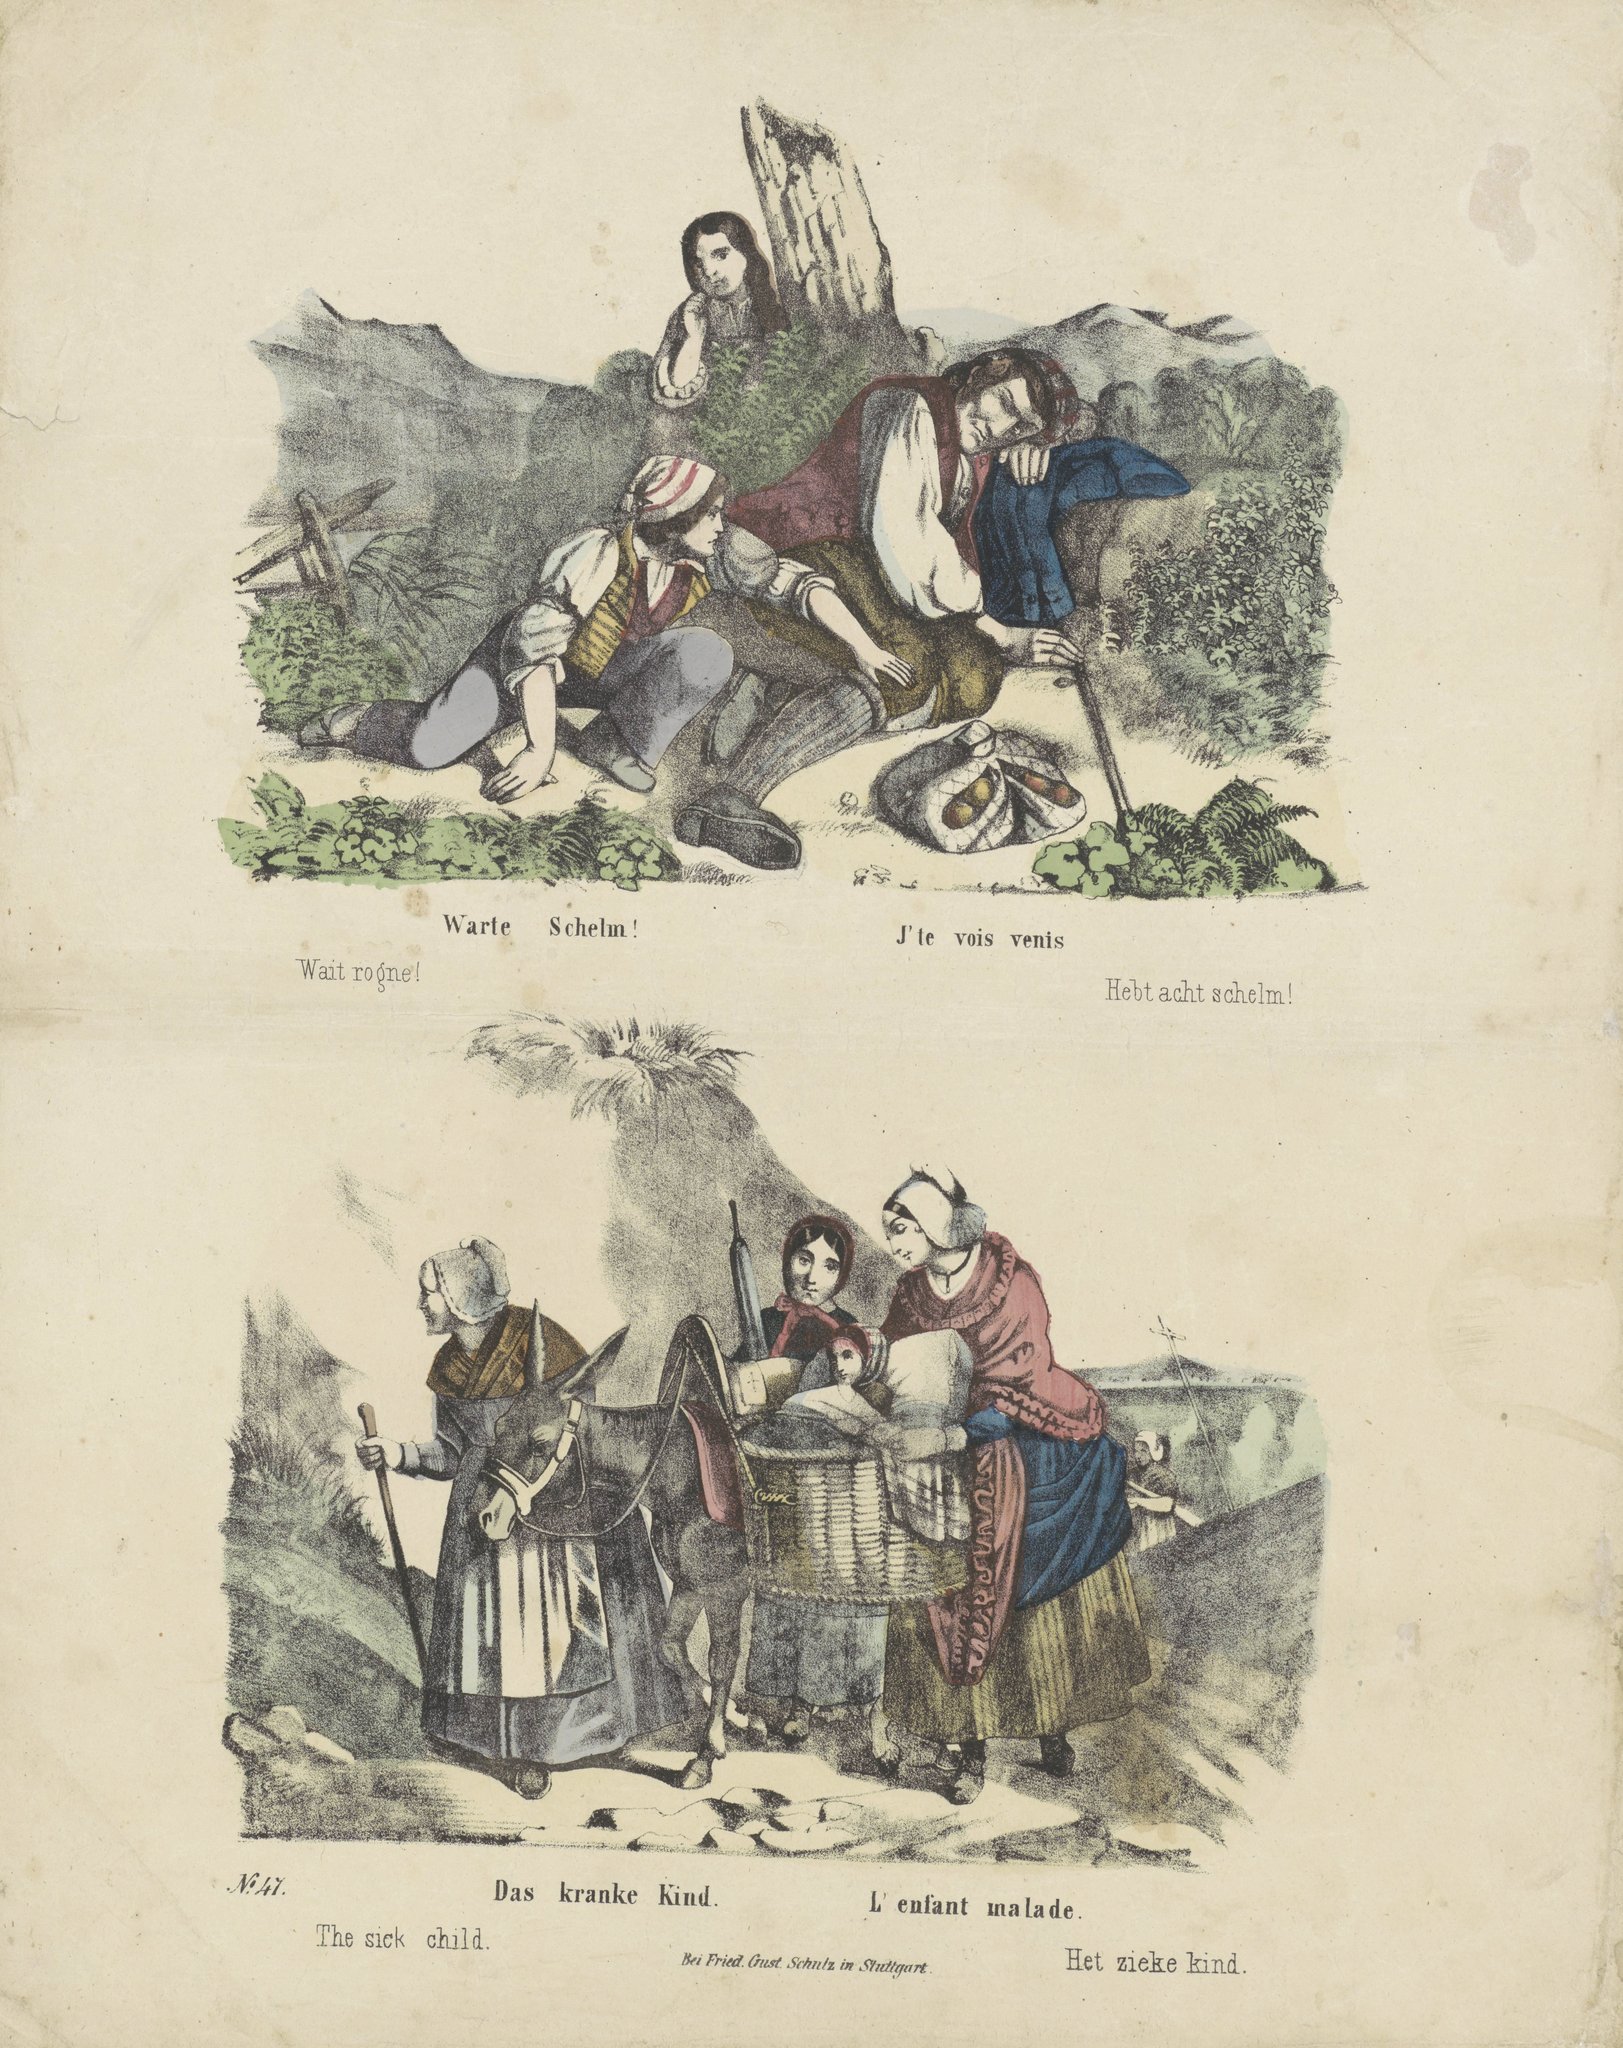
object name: print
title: Diefstal en een ziek kind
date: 1820-1865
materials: paper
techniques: colour, lithograph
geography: stuttgart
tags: ass, donkey, theft, patient, sick person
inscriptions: collector's mark: Lugt 2760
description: Blad met 2 voorstellingen. Boven: een jongen en een meisje die fruit van een slapende man proberen te stelen. Onder: drie vrouwen met een ezel die een mand met een ziek kind draagt. Onder elke afbeelding een onderschrift in het Engels, Duits, Frans en Nederlands. Genummerd linksonder: No. 47.